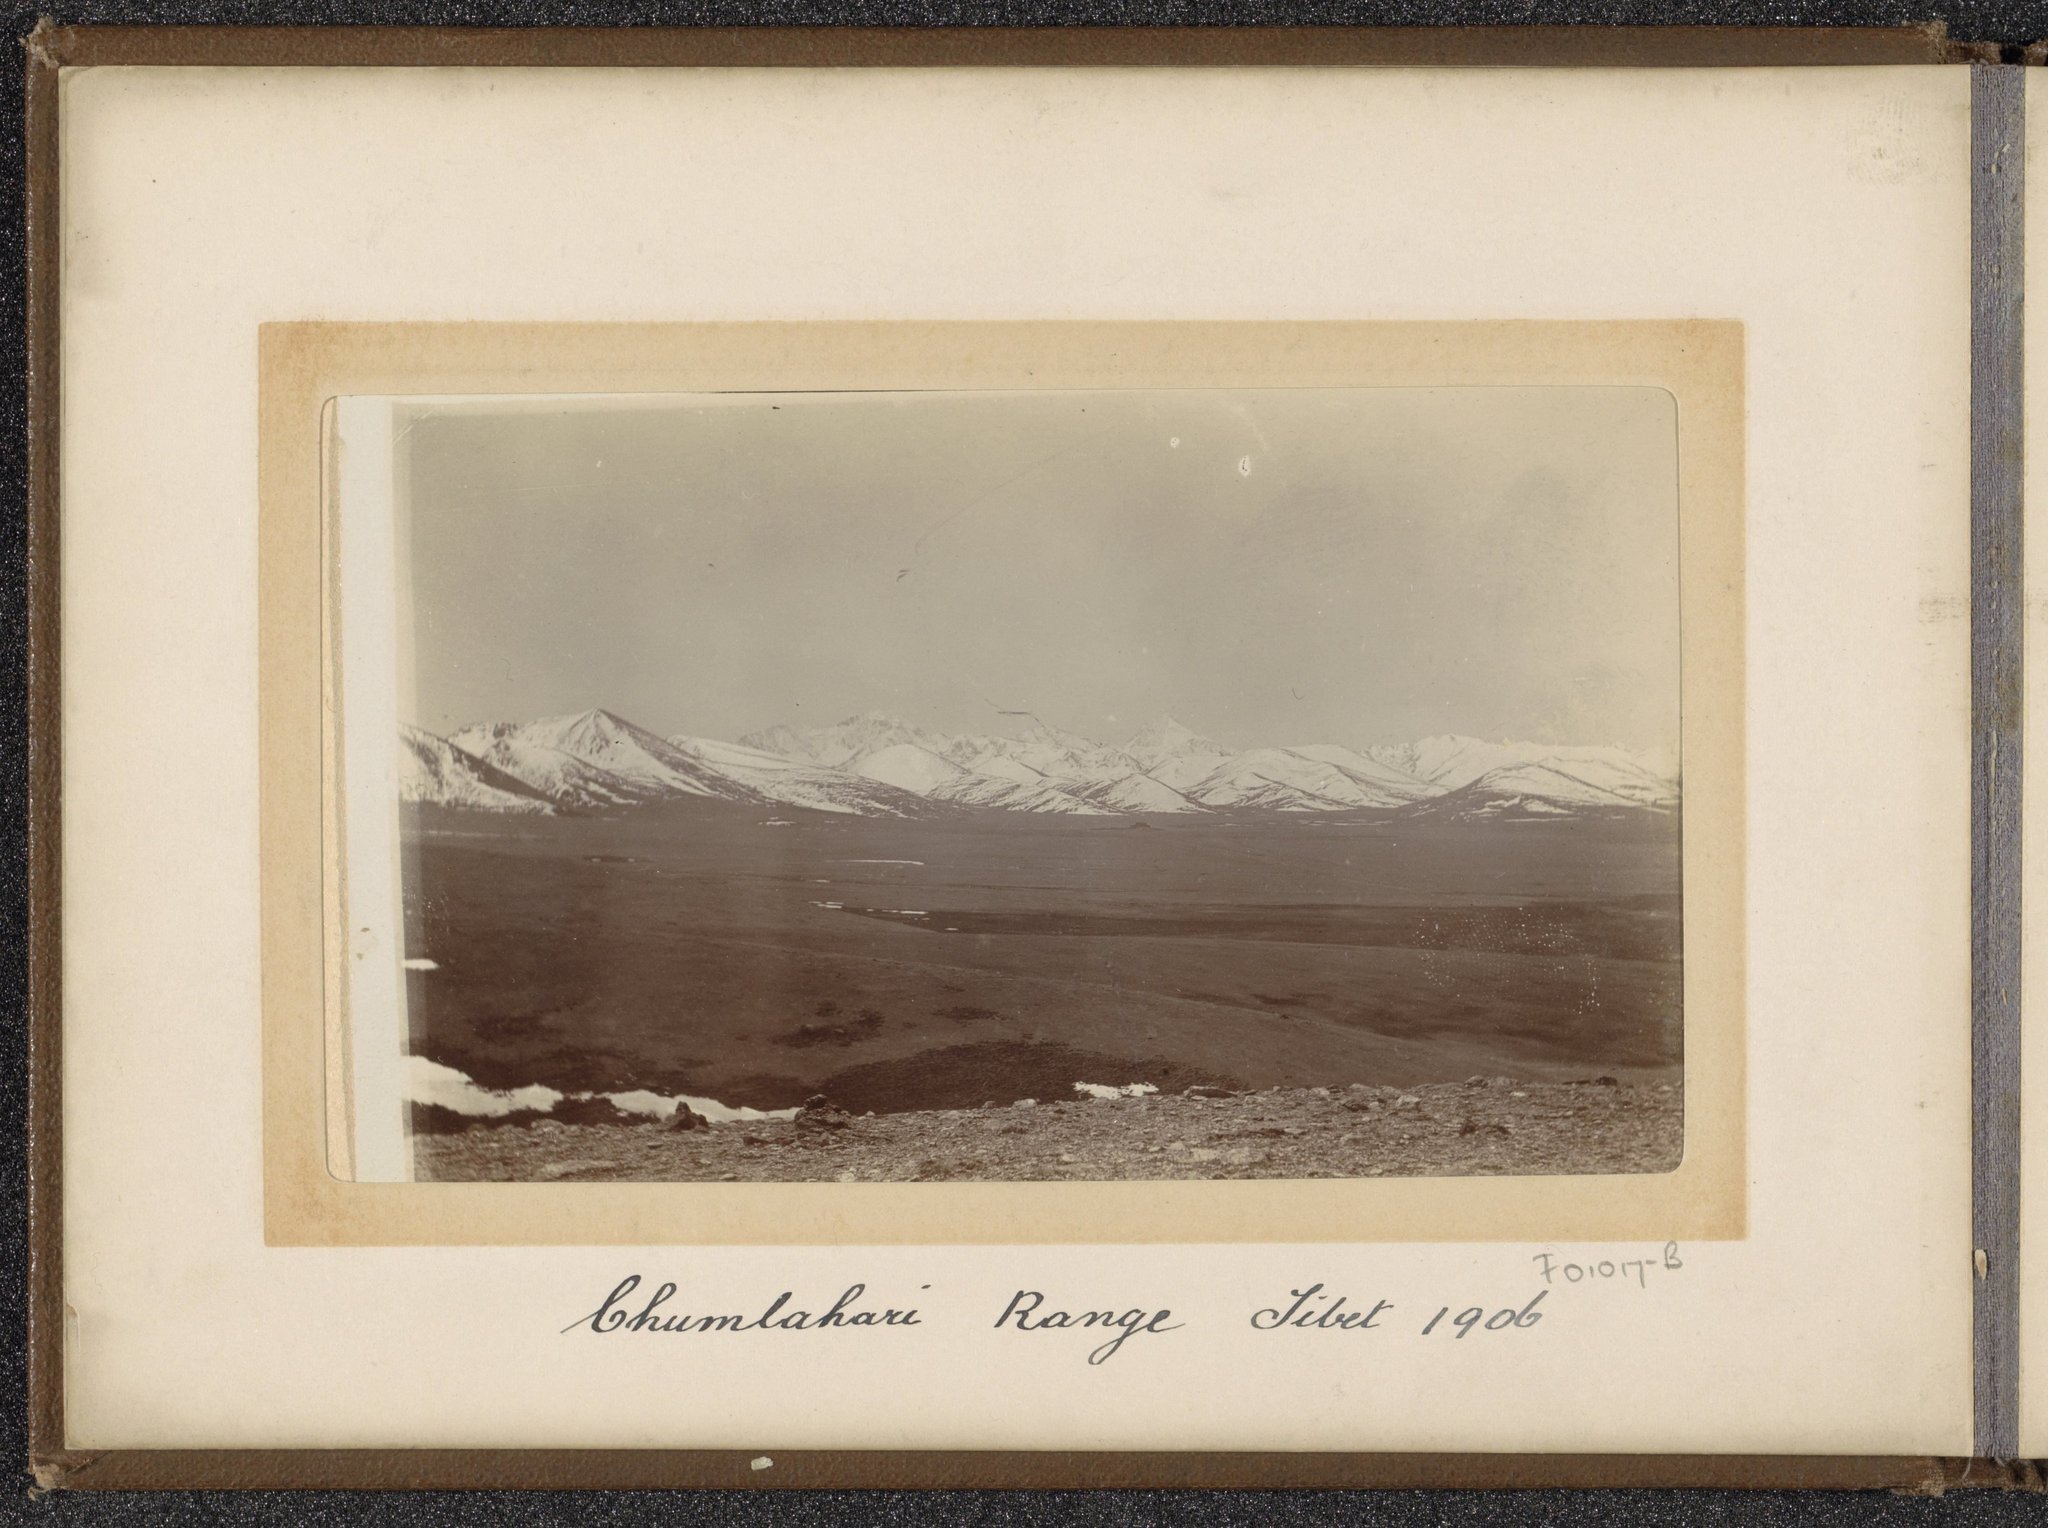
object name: photograph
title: View of a plain and the snow-capped mountain range of Chomolhari in Bhutan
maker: d.t. dalton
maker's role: sergeant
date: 1906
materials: photographic support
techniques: gelatin silver print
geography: chomolhari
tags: mountain-range, snow peaks, plain, chomolhari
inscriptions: title: ‘Chumlahari Range Tibet 1906’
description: Onderdeel van Fotoalbum met 24 foto's van de reis van legertelegrafist D.T. Dalton door Tibet.